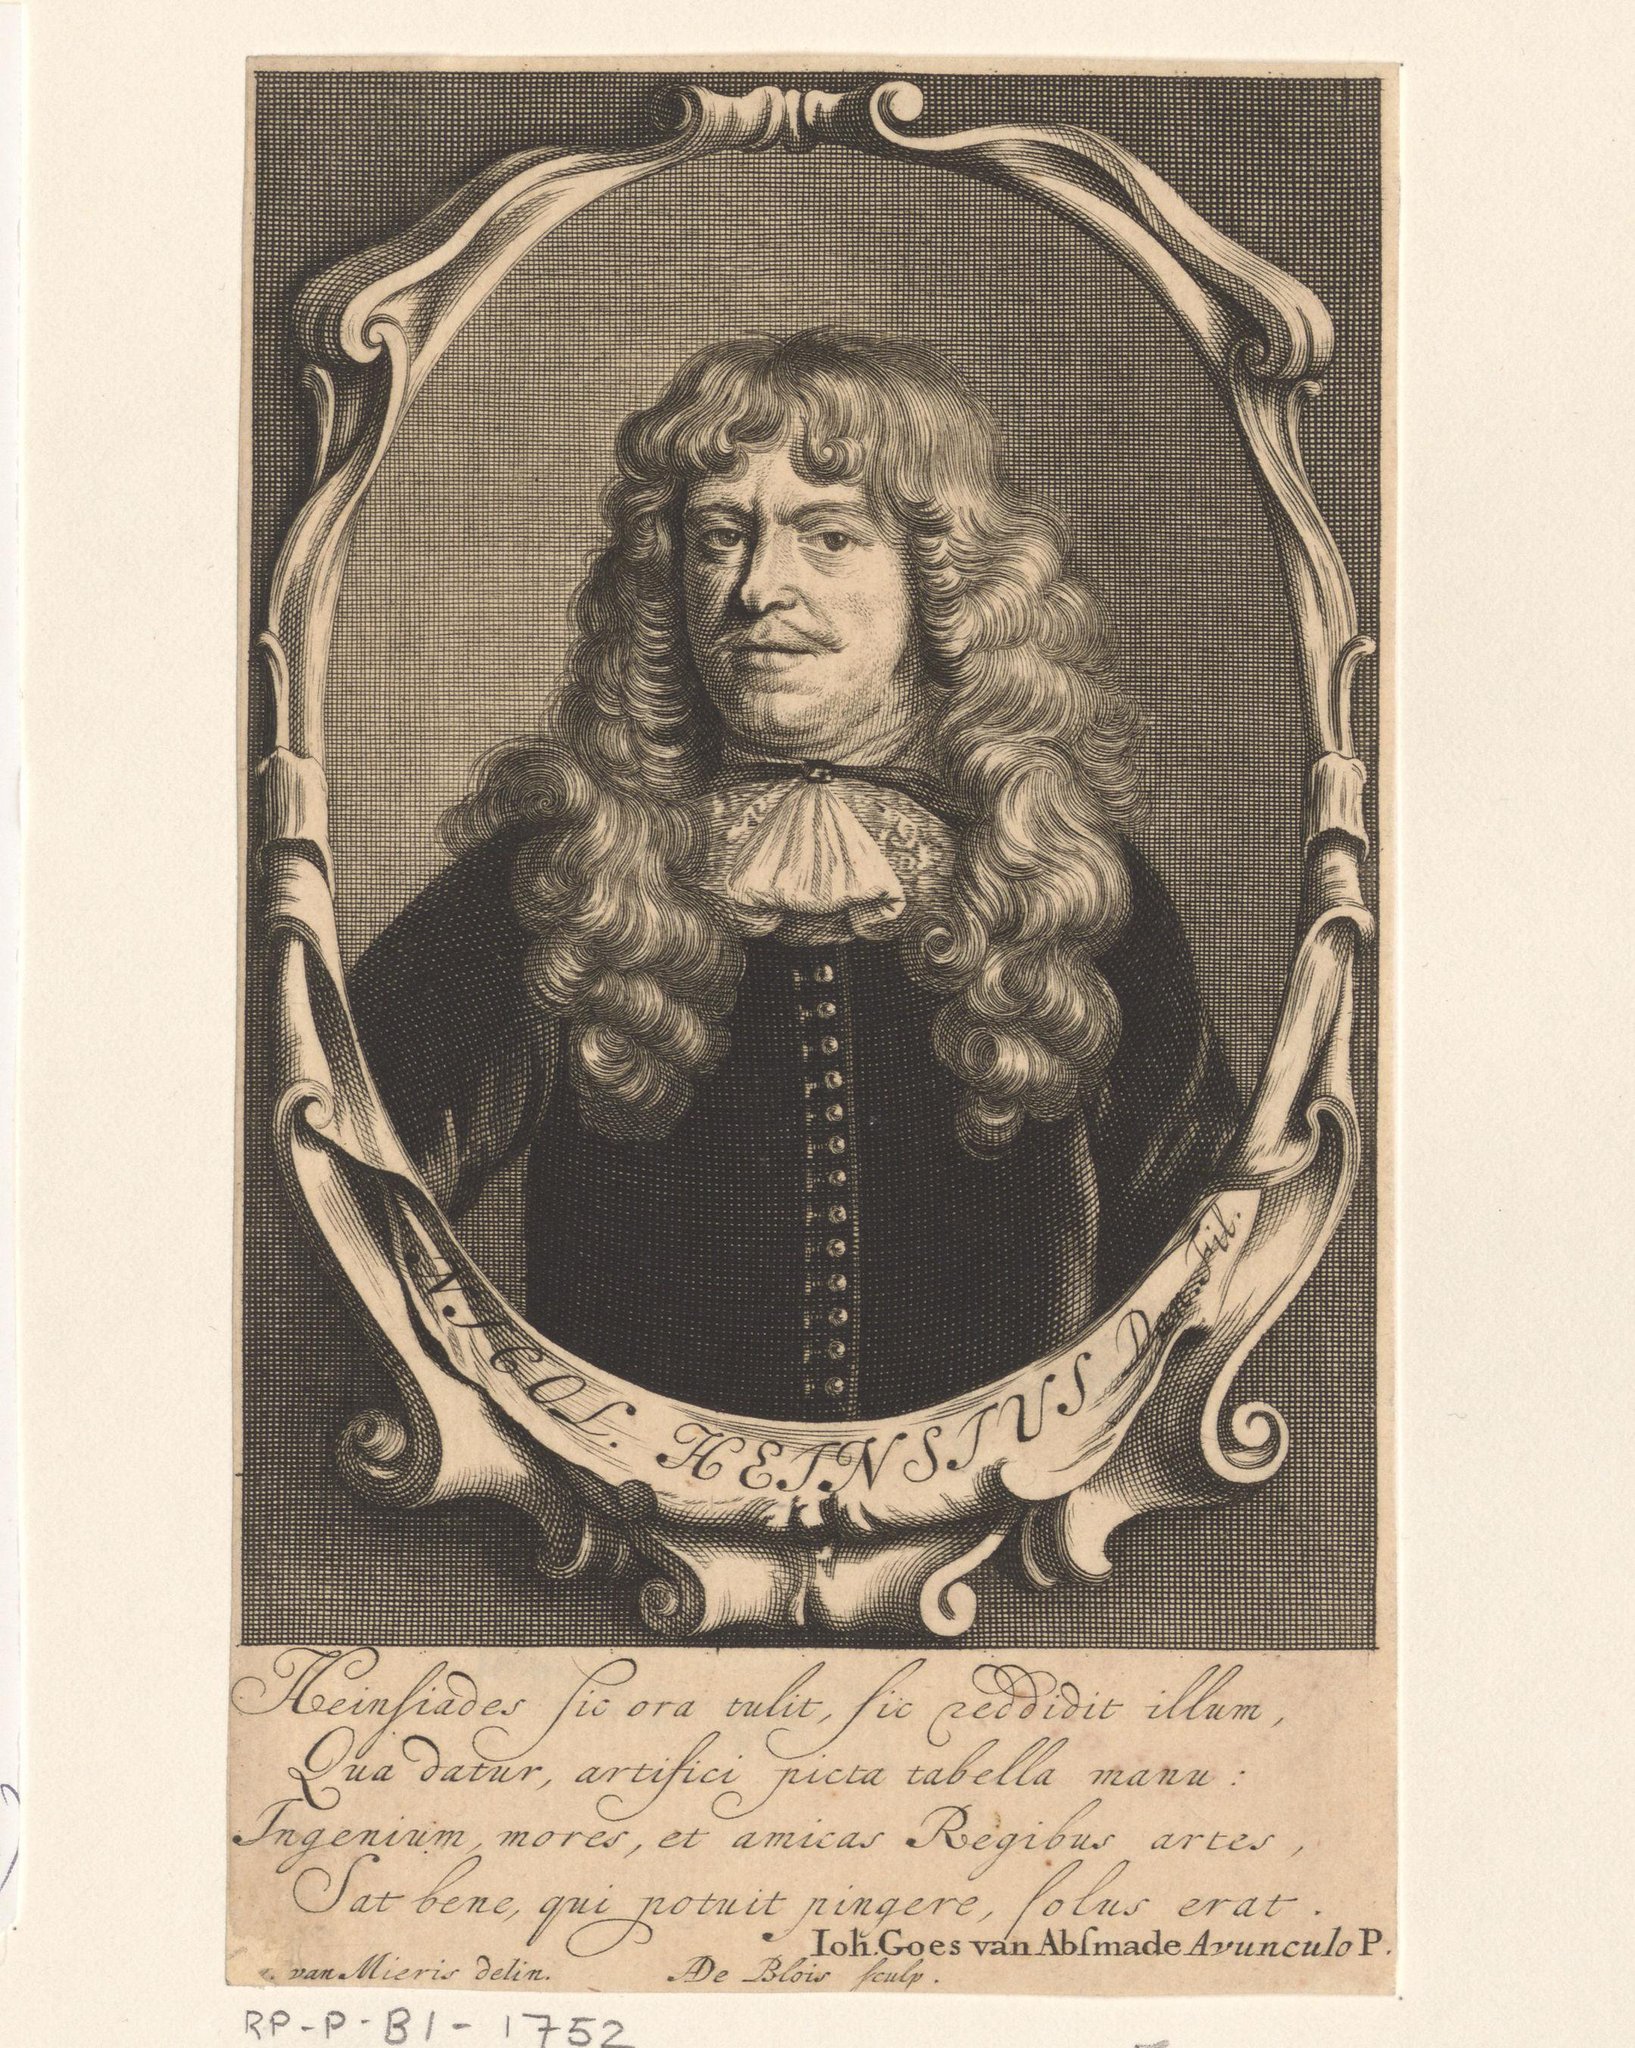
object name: print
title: Portret van Nicolaas Heinsius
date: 1689-1717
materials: paper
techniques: engraving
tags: leiden, the hague, historical persons, writer, poet, author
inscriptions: collector's mark: Lugt 240